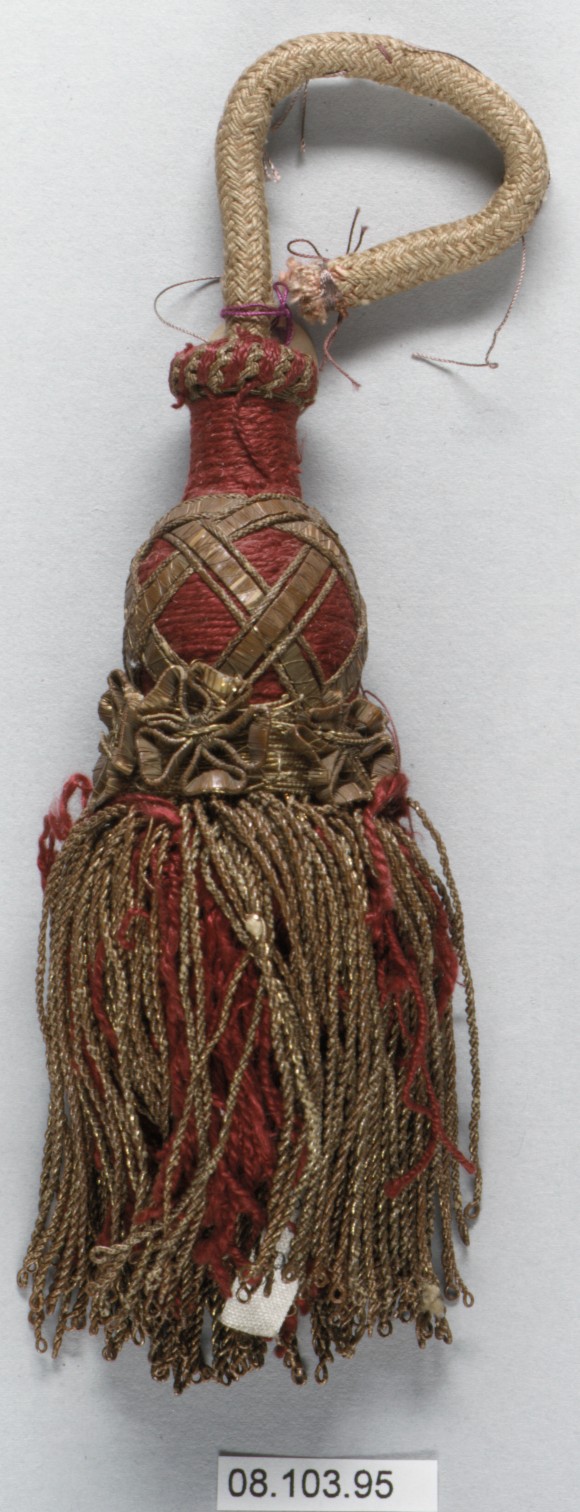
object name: tassel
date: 1801-1900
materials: metal thread, silk